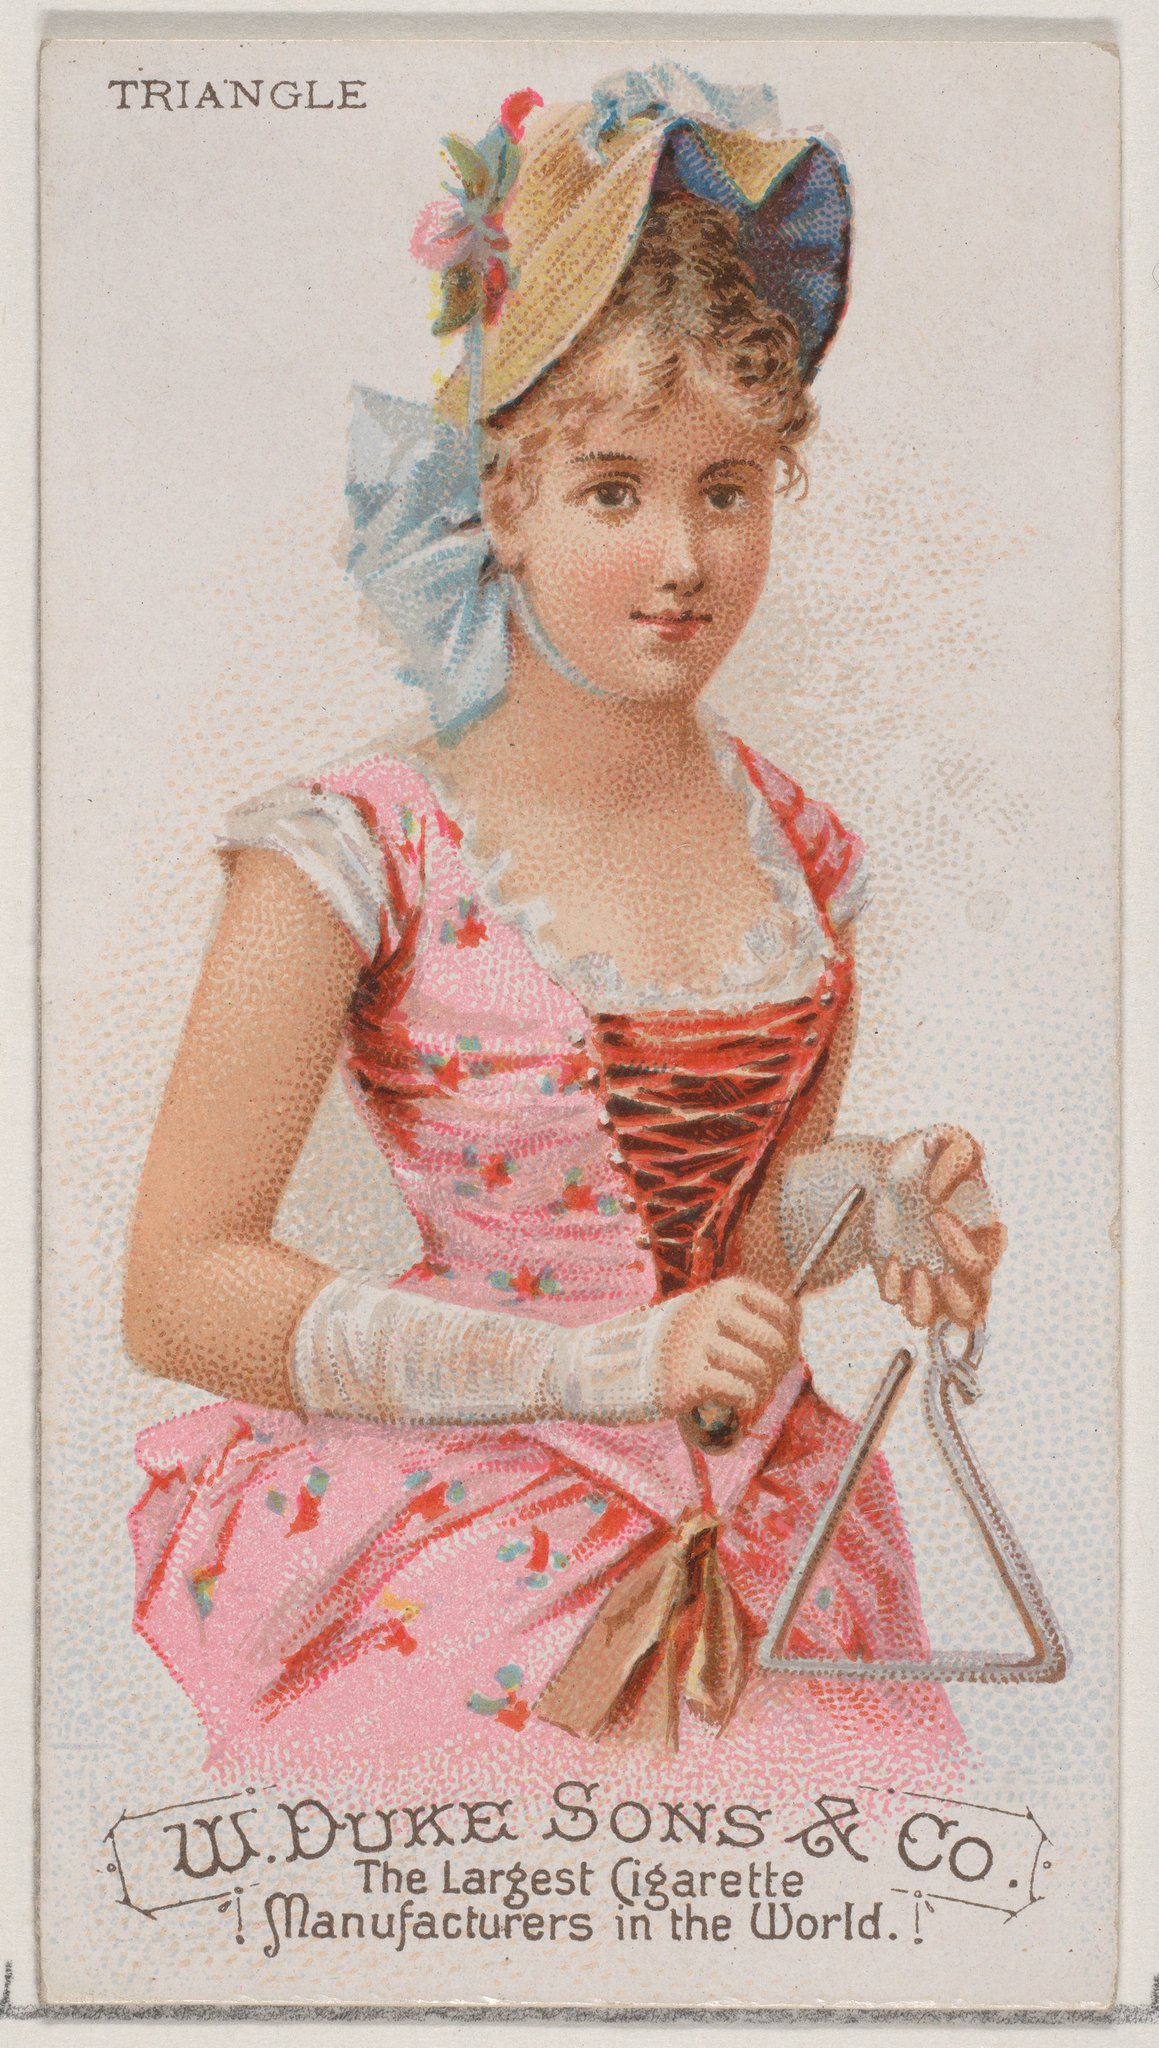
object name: print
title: Triangle, from the Musical Instruments series (N82) for Duke brand cigarettes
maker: w. duke, sons & co.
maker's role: publisher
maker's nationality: american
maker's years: 1870-1920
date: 1888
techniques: color lithograph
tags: musical instruments,women,musicians